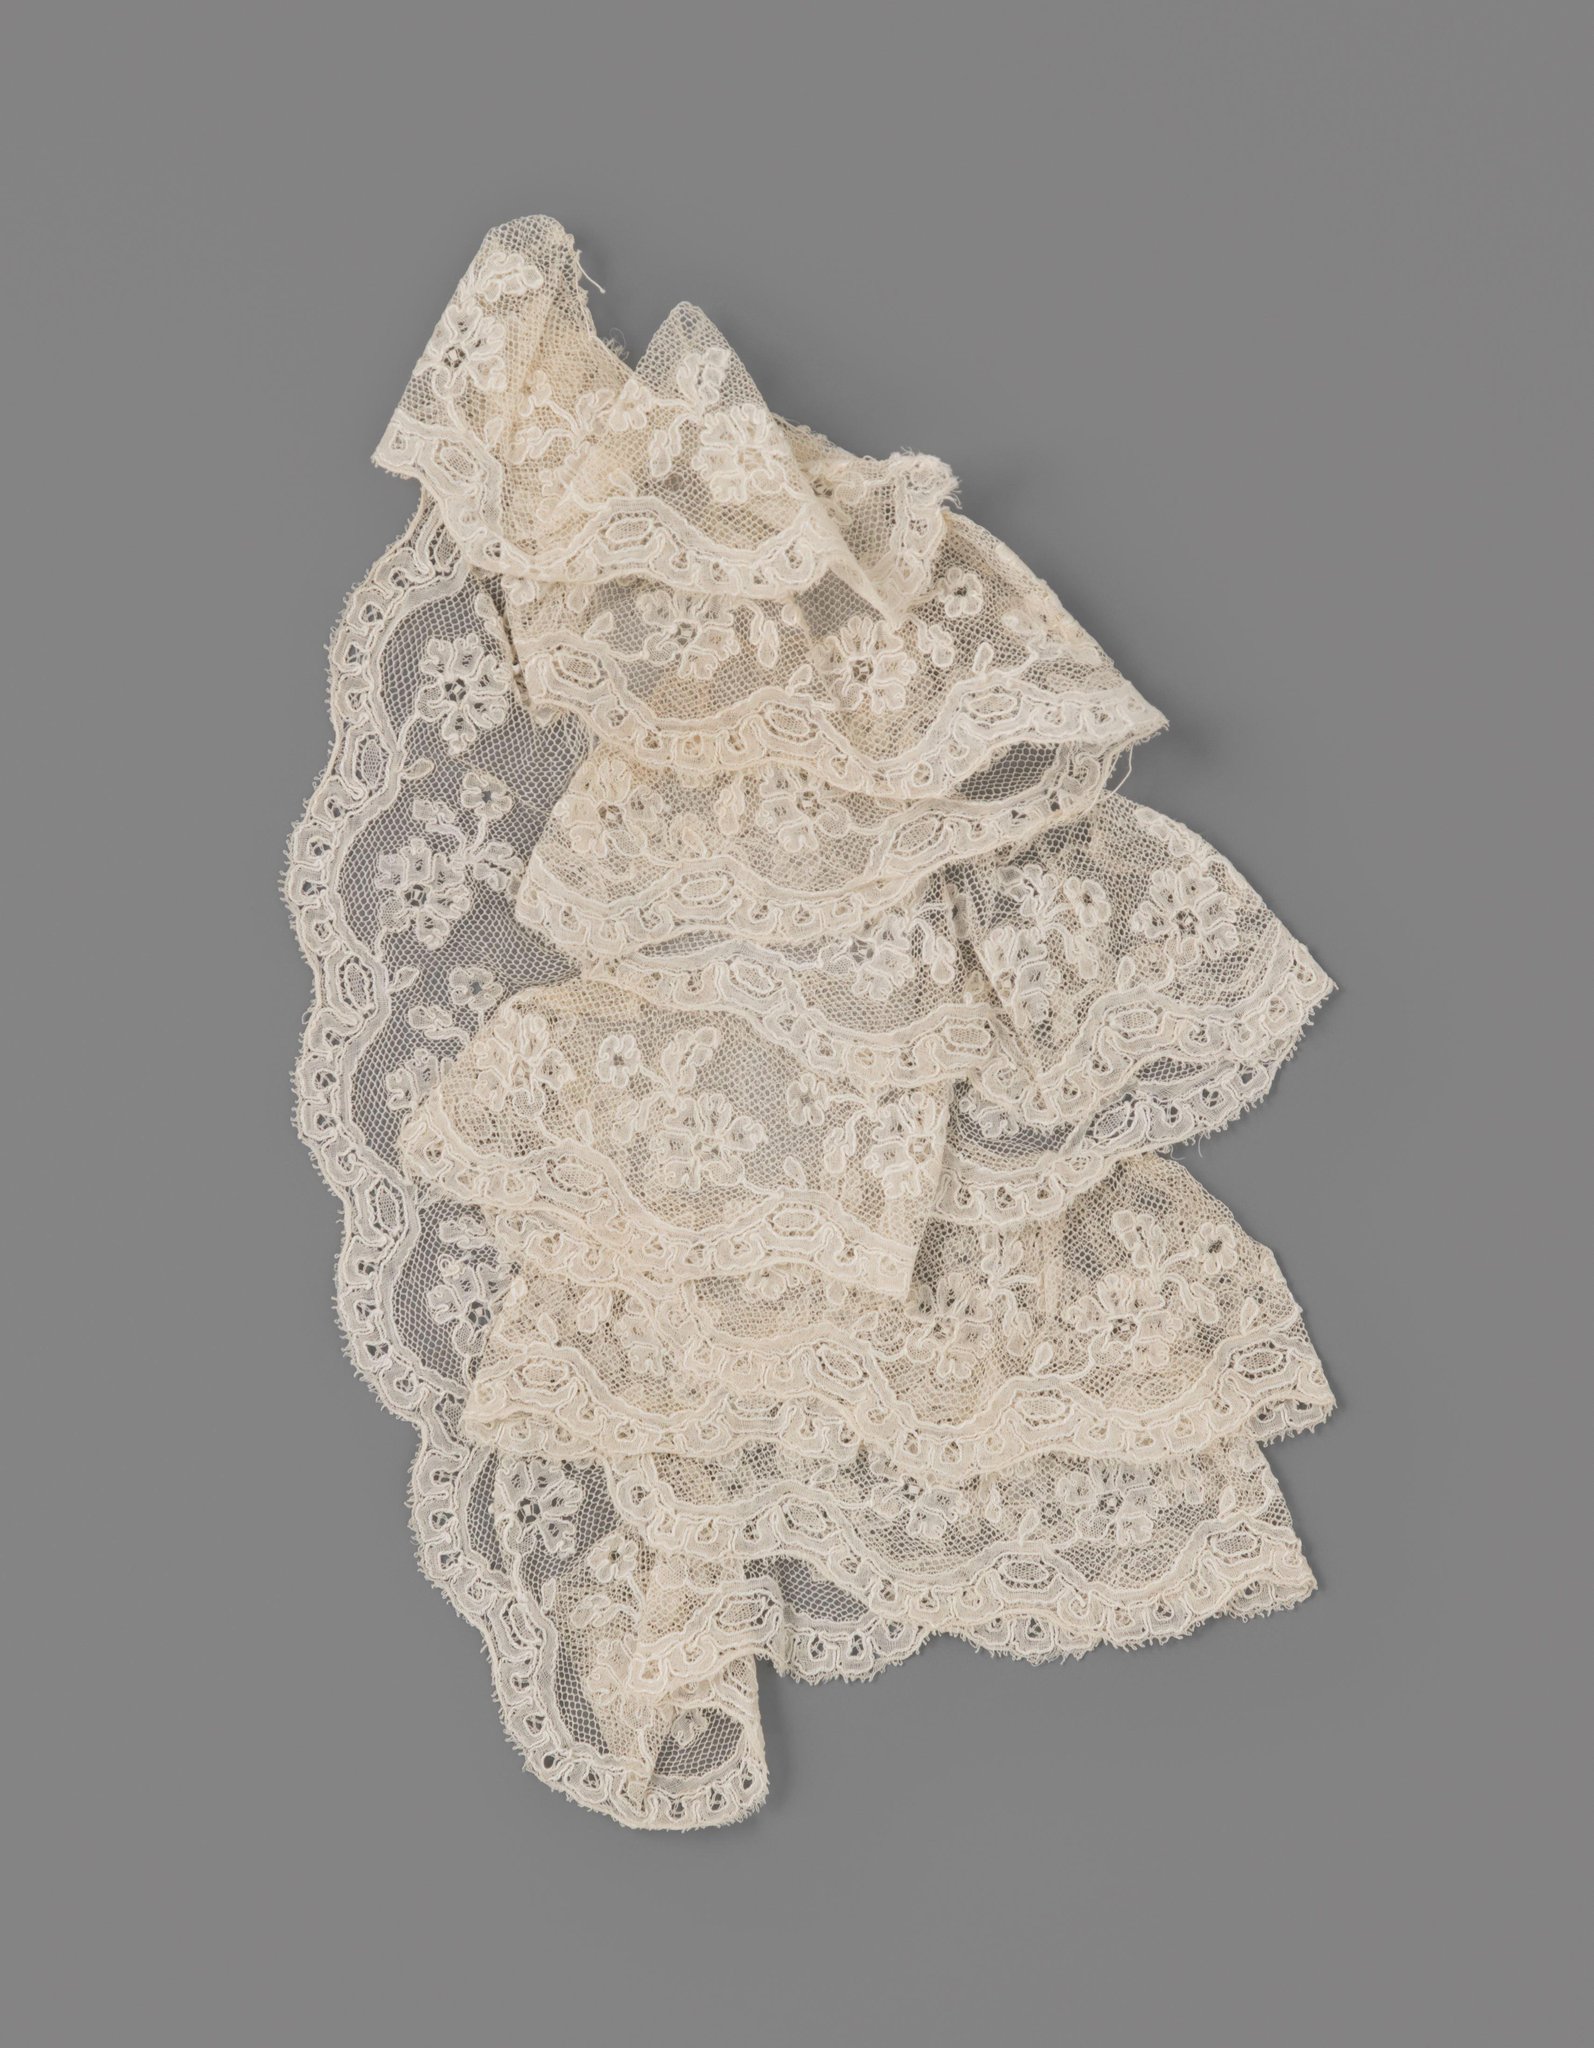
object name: jabot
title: Jabot van Mechelse kant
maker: Anonymous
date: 1850-1875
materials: cotton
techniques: lace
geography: mechelen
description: Jabot van rechthoekige stuk batist en mechelse kant. Tule middenstuk en aangenaaide brede kanten strook in plisé-vorm. Kant versierd met een geschulpte rand met roos en maaiermotief, een vierkant in gedeelde bies waaruit een eenvoudige bloemtak op komt.